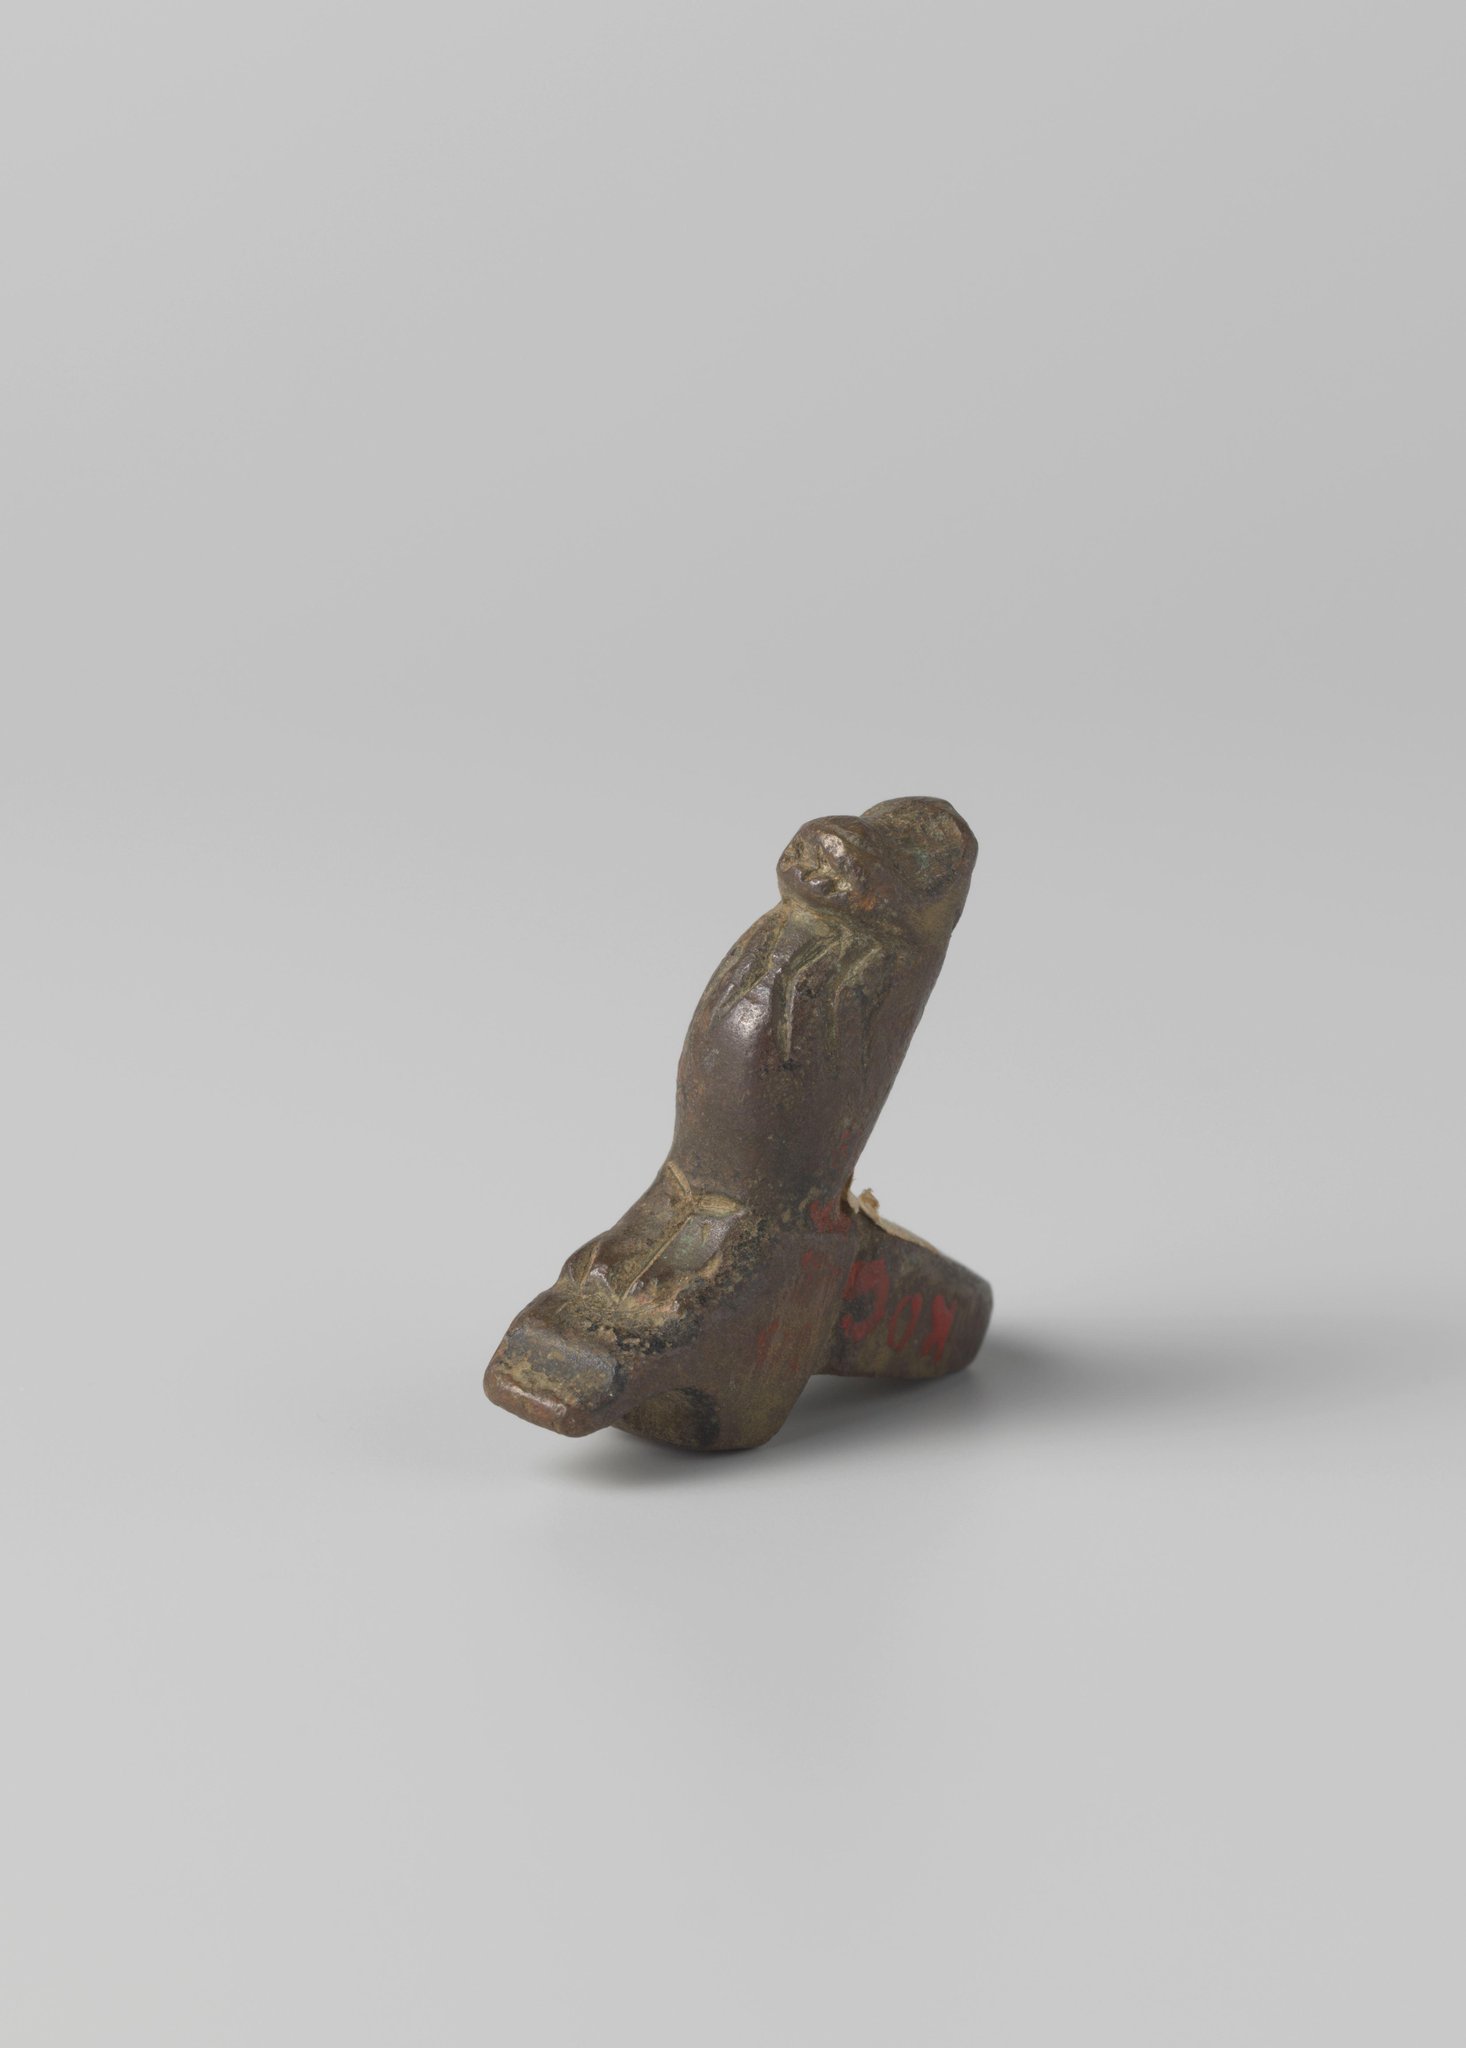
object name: sculpture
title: Bronzen voet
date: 1400-1425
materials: bronze